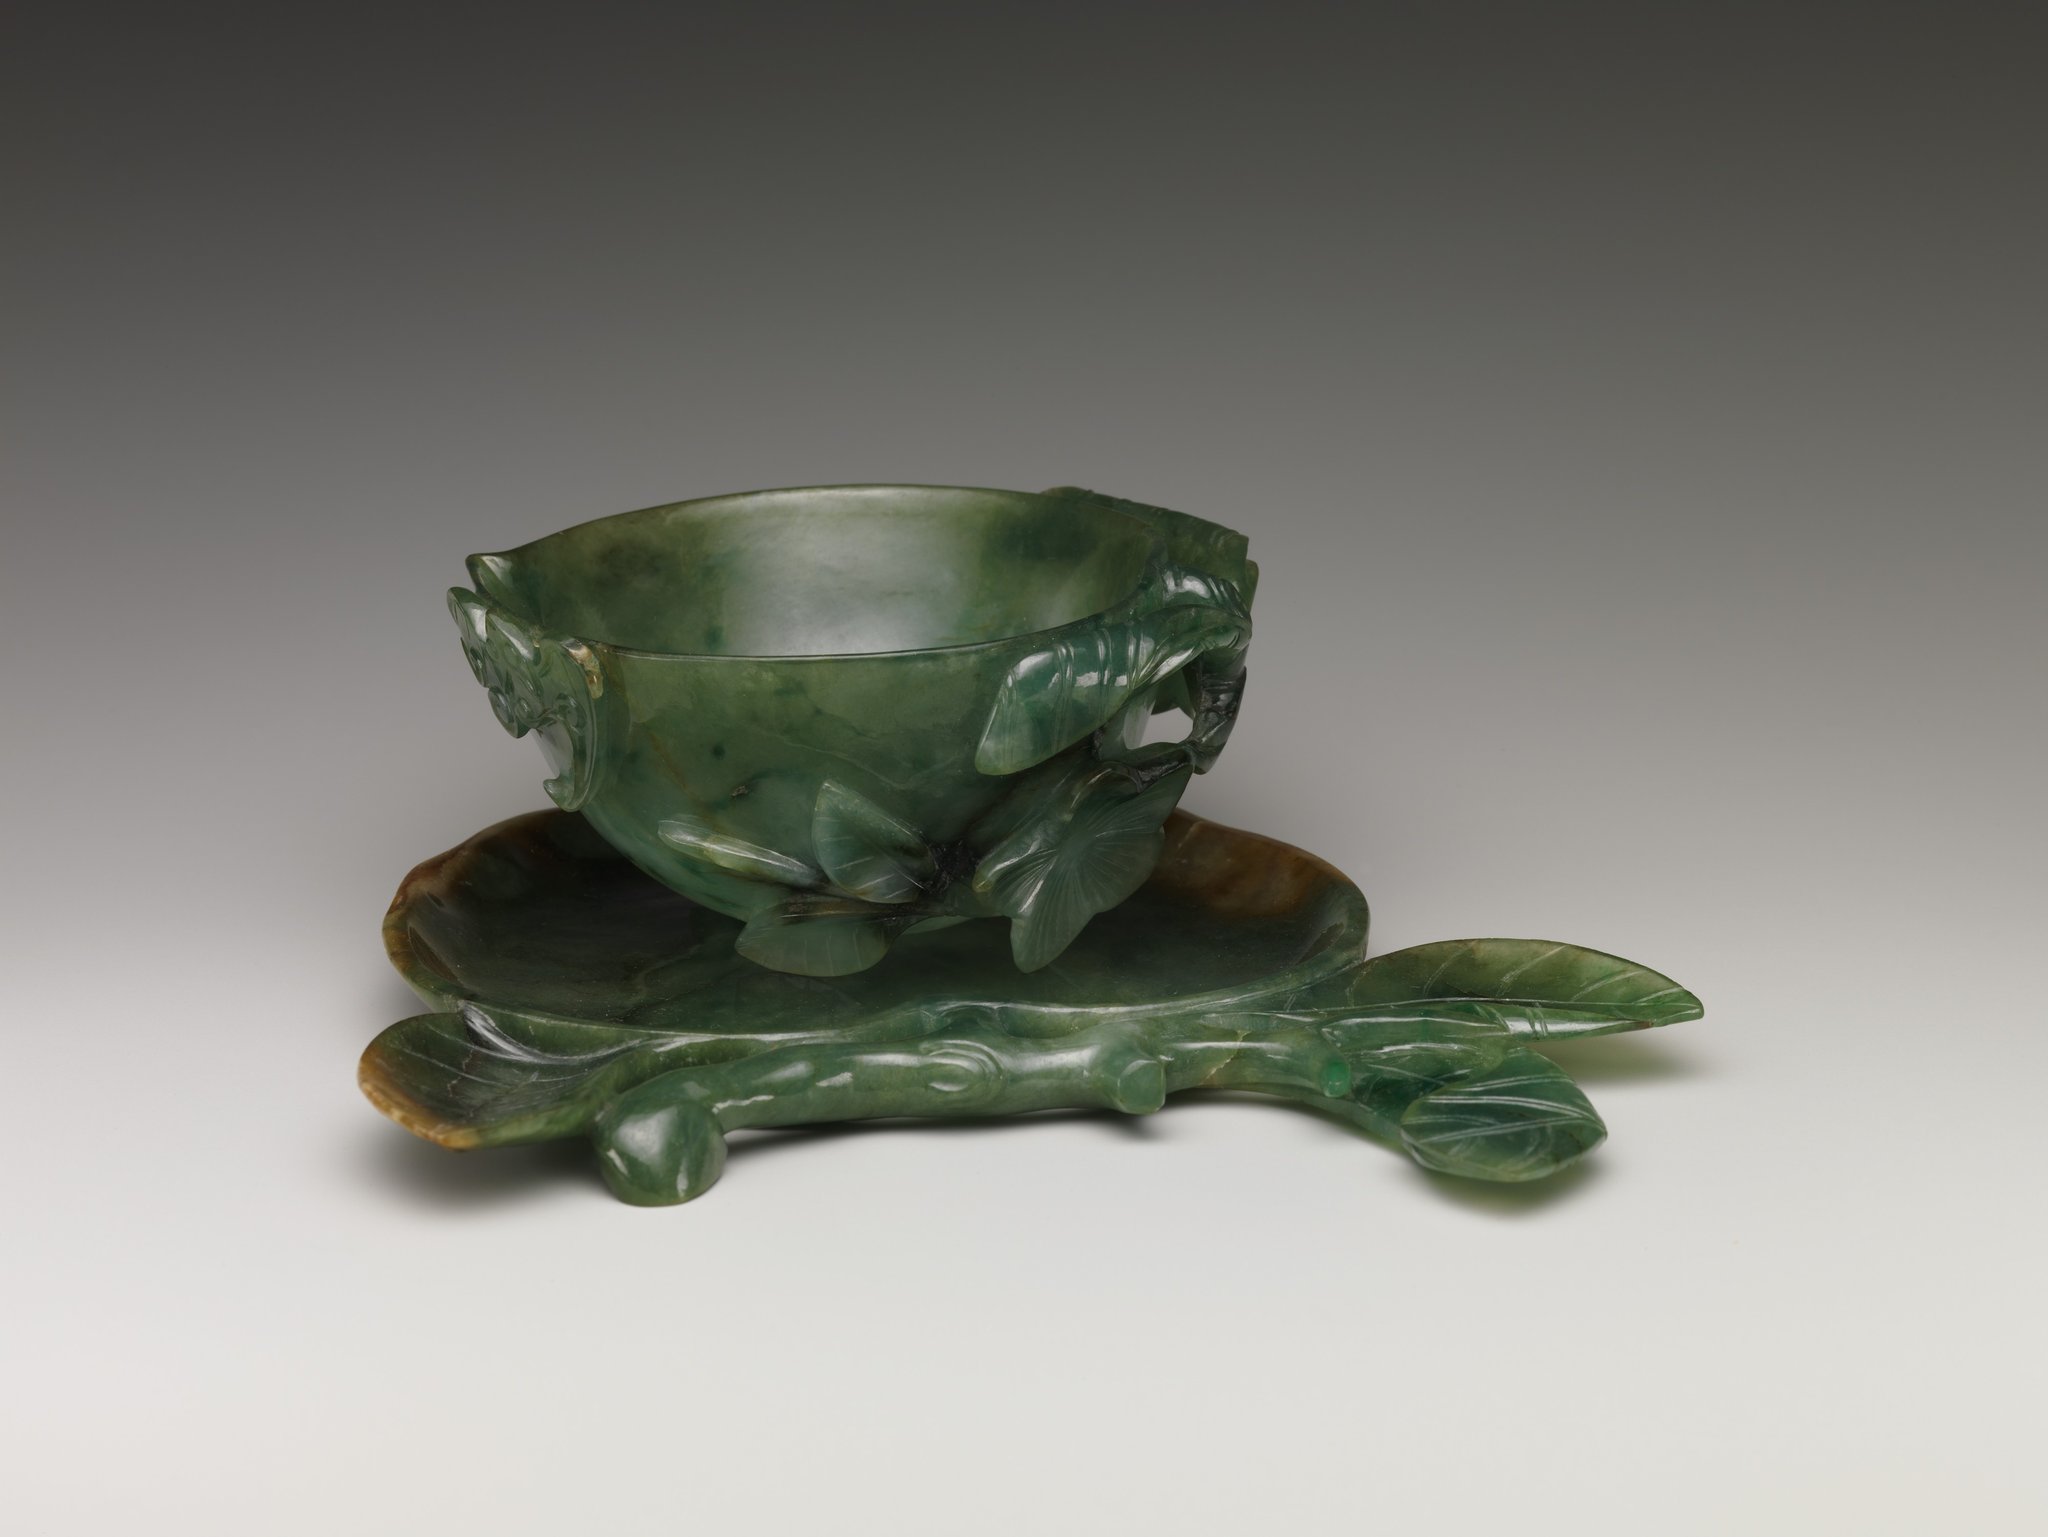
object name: cup and saucer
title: Peach-shaped Cup with Saucer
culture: chinese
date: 1801-1900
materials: jade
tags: leaves